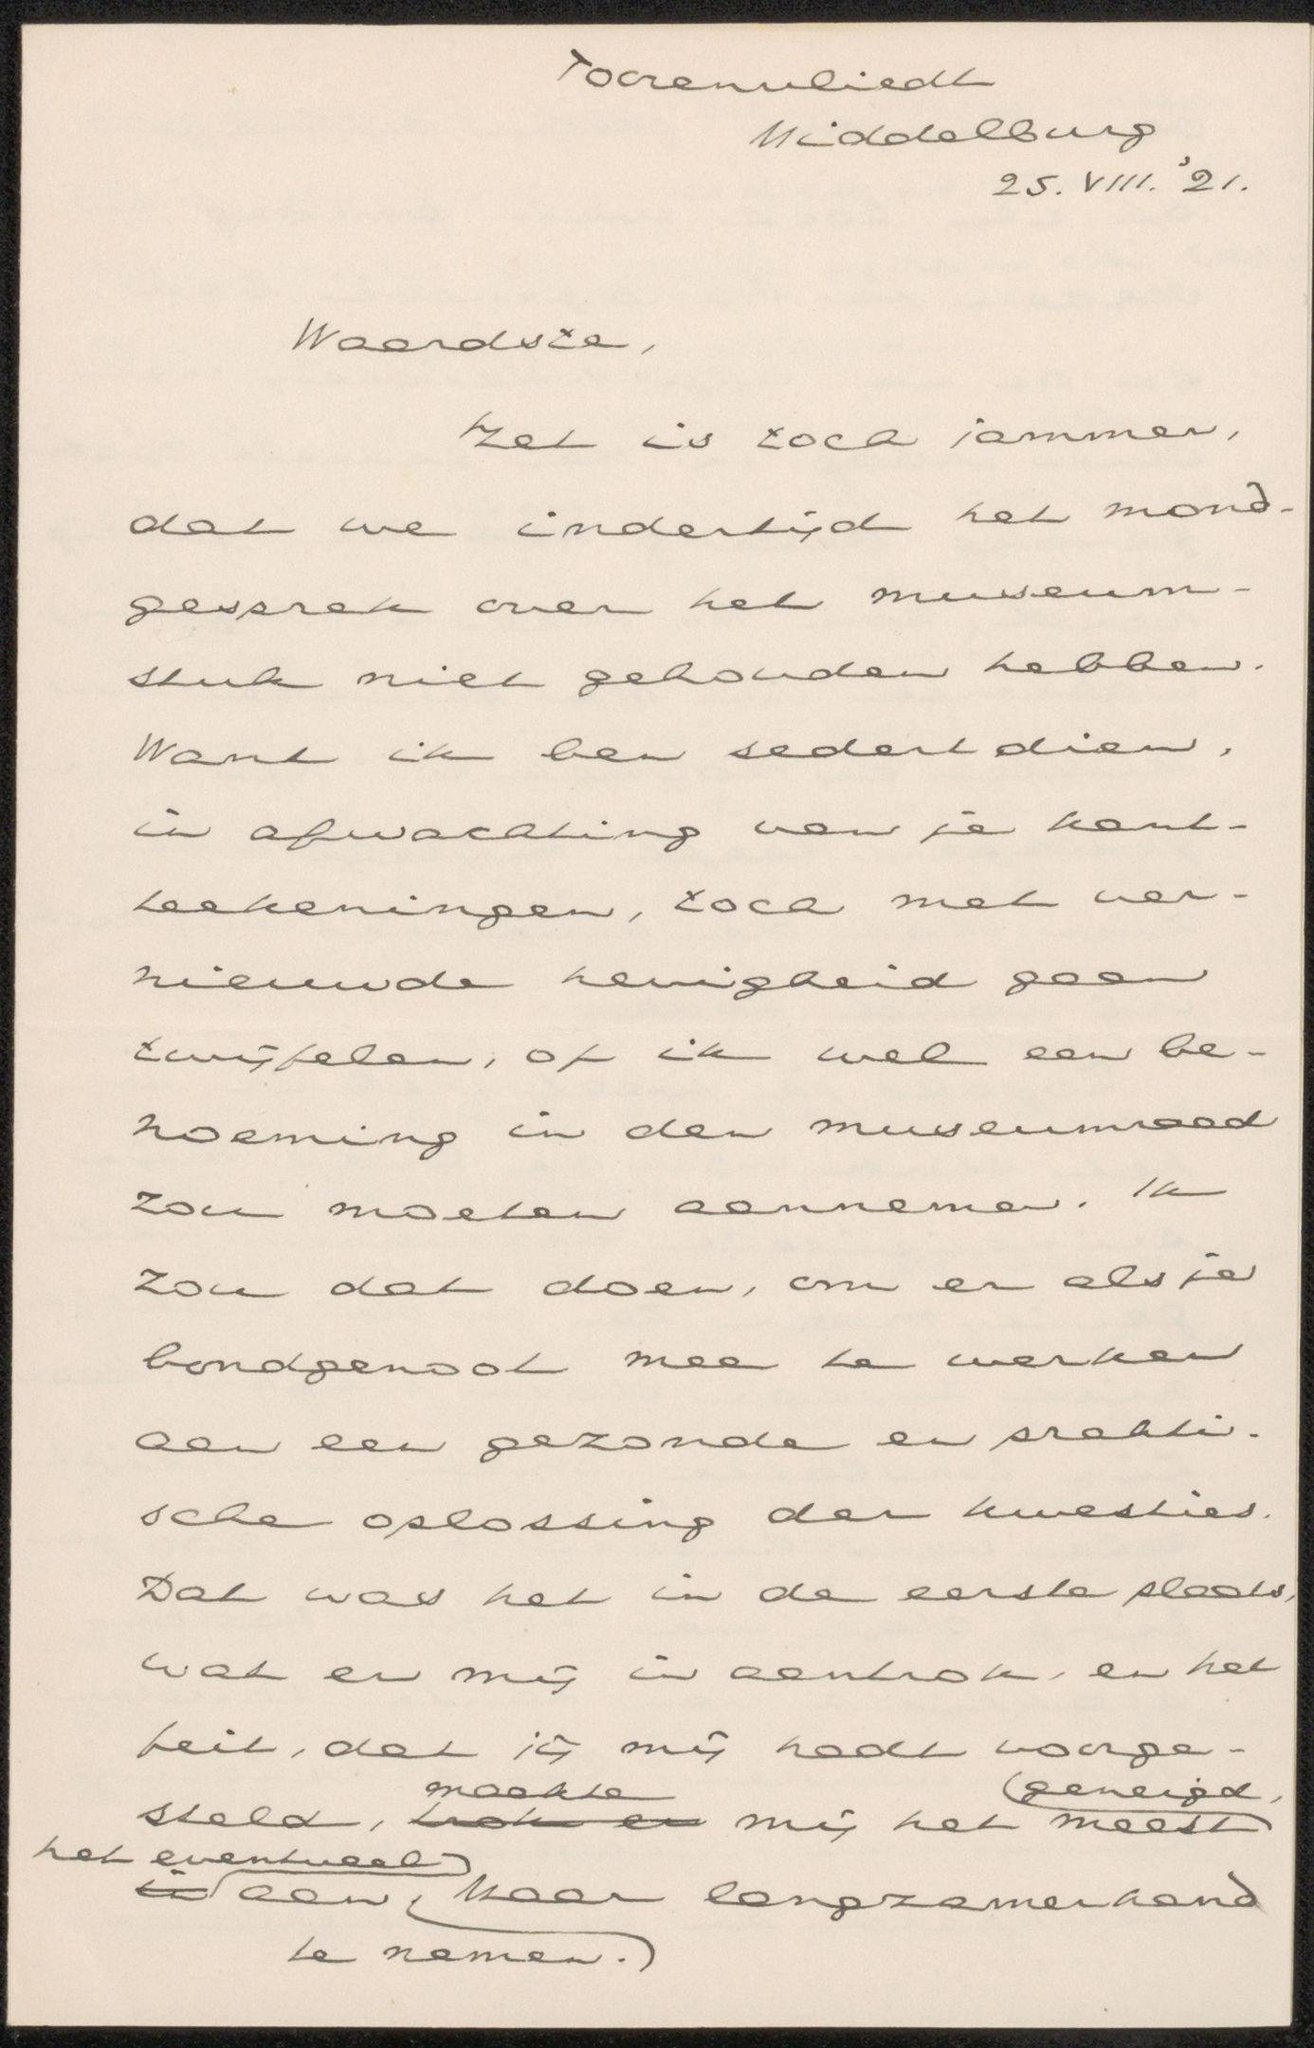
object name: letter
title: Brief aan Jan Veth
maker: johan huizinga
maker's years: 1872-1945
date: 1921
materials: ink, paper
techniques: pen, writing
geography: middelburg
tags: amsterdam, painter, draughtsman, designer, jan veth, samuel muller (1848-1922), andré jolles, paris, mozes isaac duparc, rotterdam, family life, travelling; tourism, printed matter, leiden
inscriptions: collector's mark: ‘RPK’, watermark